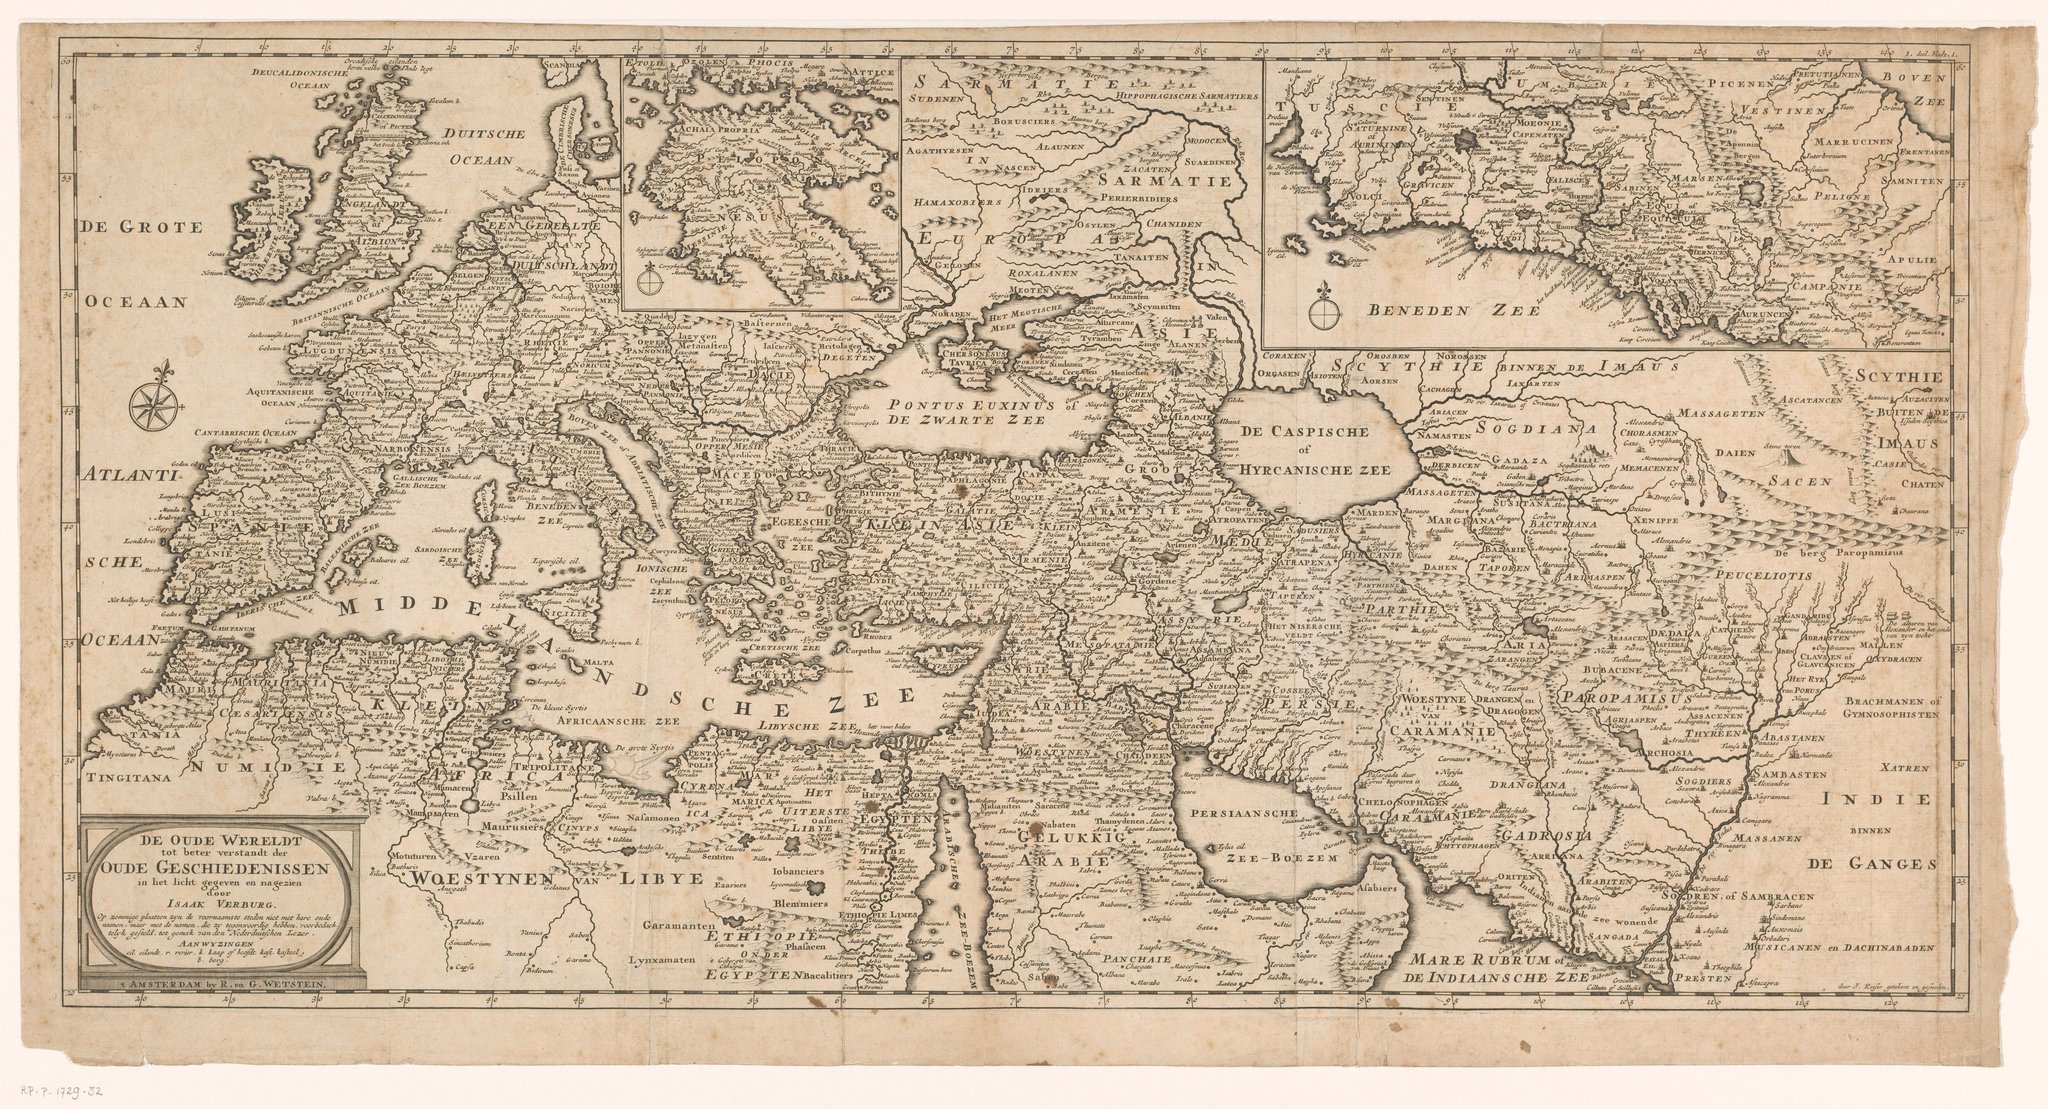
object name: print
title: De oude wereldt tot beter verstandt der oude geschiedenissen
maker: j. keiser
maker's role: print maker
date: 1728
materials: paper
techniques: engraving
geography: amsterdam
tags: (map of) asia, (map of) africa, (map of) europe, italy, europe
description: Kaart van de oude wereld. Linksonder de titelcartouche met onderin een verklaring van gebruikte afkortingen. Rechtsboven een inzet met een kaart van een deel van Italië. Boven, links van het midden, een inzet met een kaart van de Peloponnesos. De kaart is voorzien van een gradenverdeling langs de randen. Rechtsboven gemerkt: 1. deel. bladz. 1.